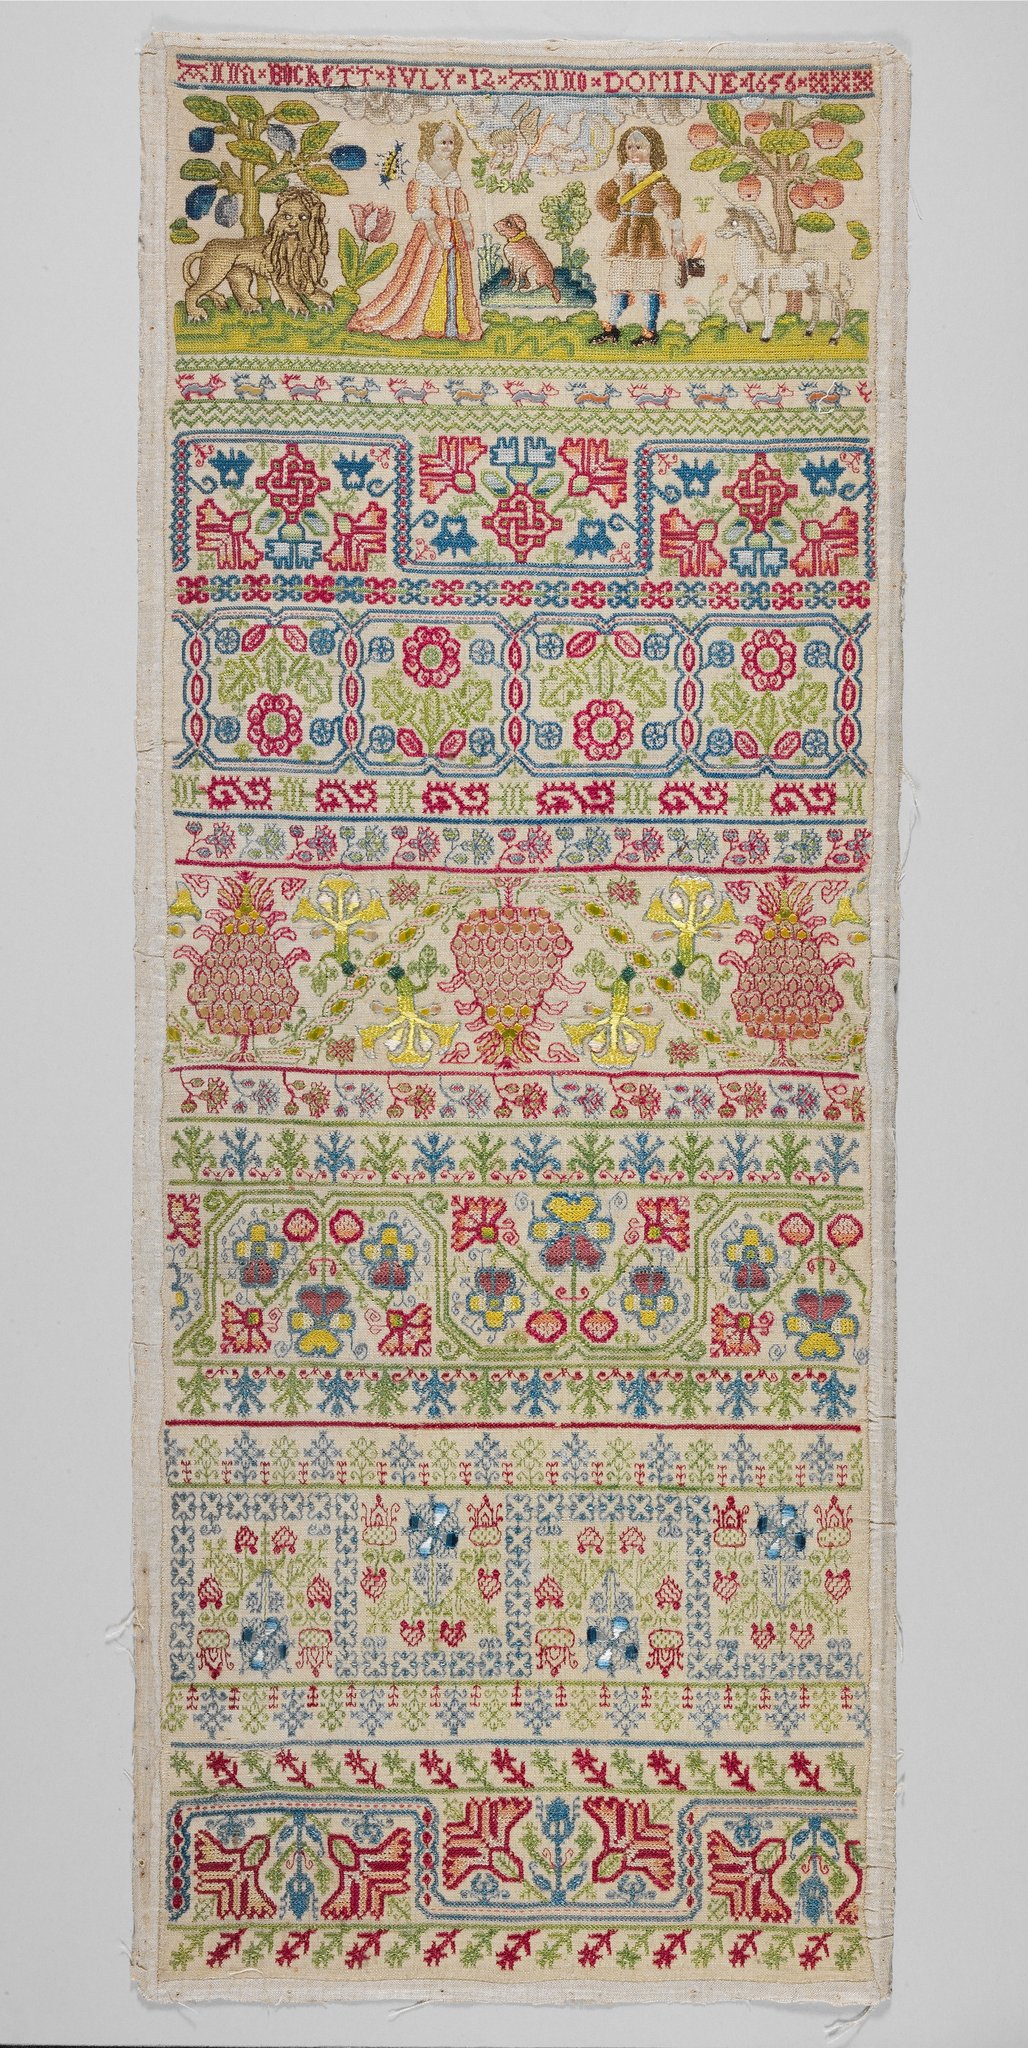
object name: sampler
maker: anna buckett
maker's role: maker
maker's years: 1600-1700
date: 1656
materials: linen, textile, thread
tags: men,women,cupid,unicorns,dogs,lions